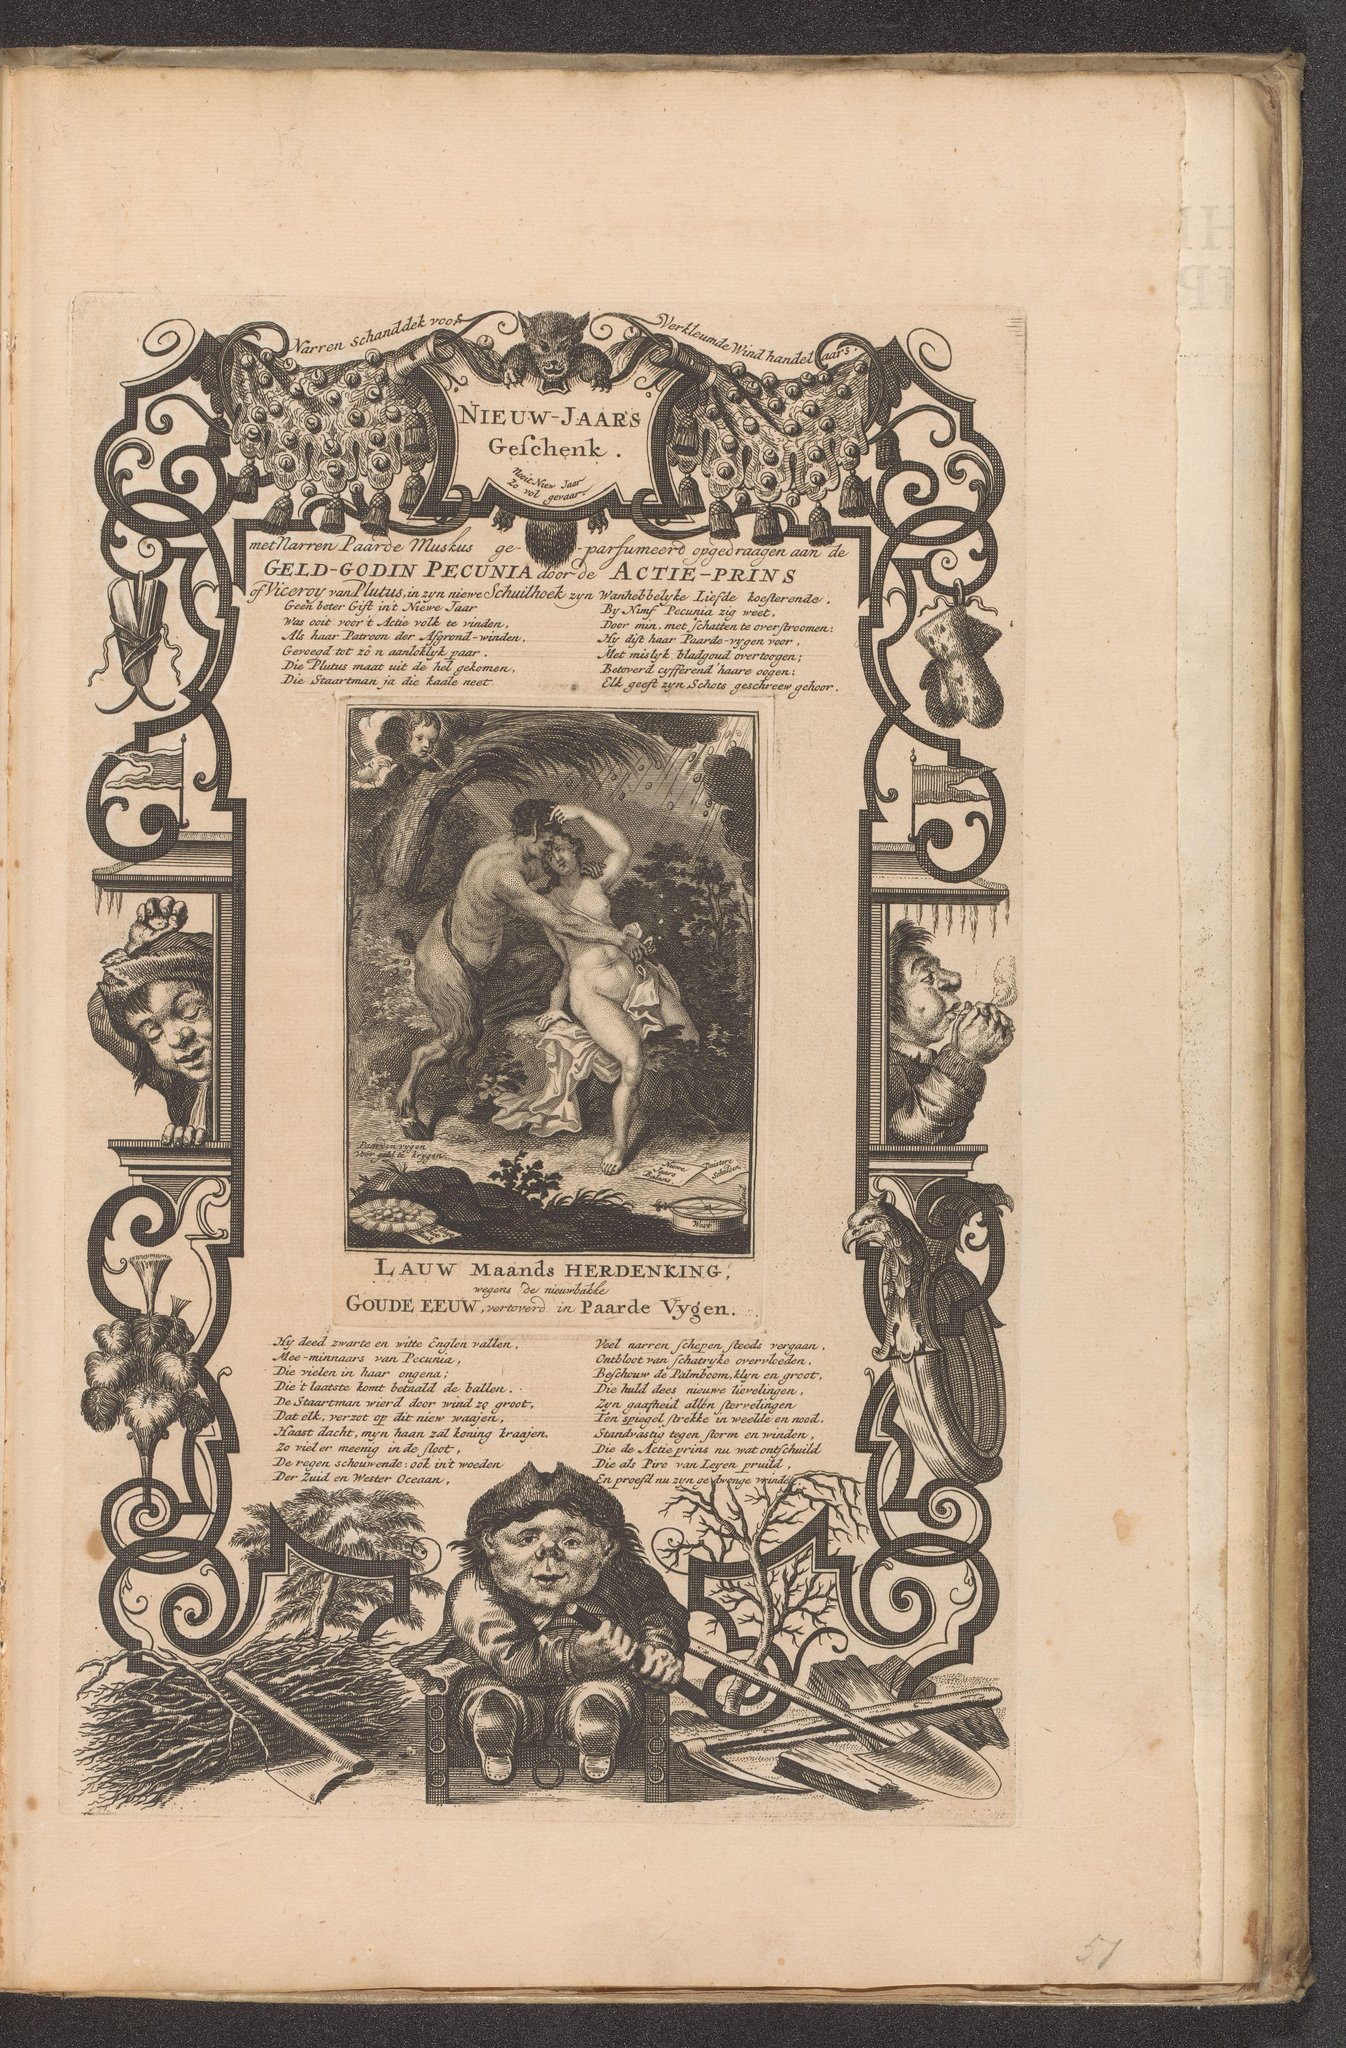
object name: cartoon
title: Nieuw-Jaars Geschenk / Lauw Maands Herdenking, wegens de nieuwbakke Goude Eeuw, vertoverd in Paarde Vygen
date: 1720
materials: paper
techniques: engraving, etching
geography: northern netherlands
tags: little people, satyr(s) pursuing nymph(s)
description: Spotprent met de Lauwmaand herdenking. Centrale voorstelling van een aparte plaat met een sater (Staartman = John Law) die een nimf (Pecunia) het hof maakt, met drieregelig onderschrift. In een omlijsting met kleine mensen en attributen van de winter, met onderschrift met twee verzen. Prent in de gebonden eerste uitgave (304 B 10) van Het Groote Tafereel der Dwaasheid met spotprenten op de Windhandel of Actiehandel van 1720.